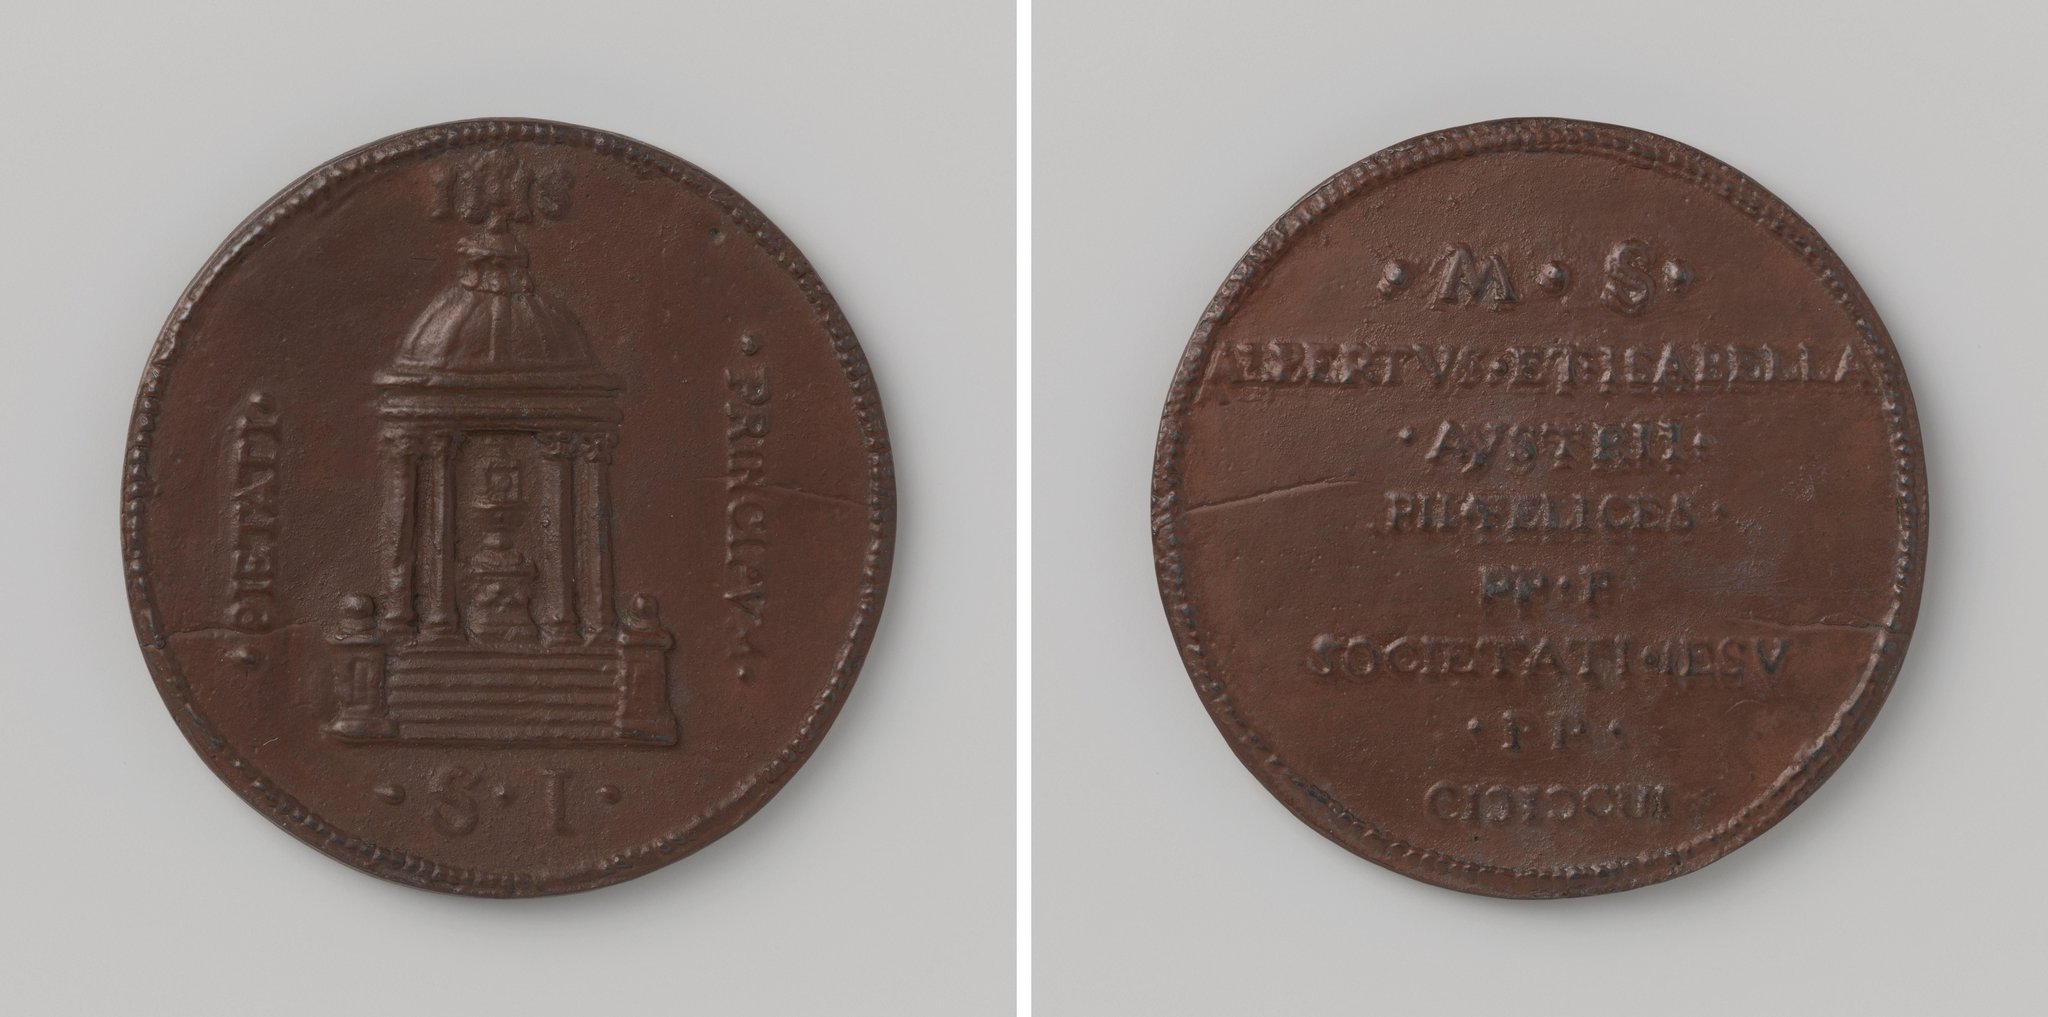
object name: copy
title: Legging van de eerste steen van de Jezuietenkerk te Brussel door Albrecht en Isabella van Oostenrijk, penning gelegd onder fundamenten van nieuwbouw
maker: Anonymous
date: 1600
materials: bronze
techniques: casting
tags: infante van spanje isabella clara eugenia, brussels, albrecht aartshertog van oostenrijk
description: Bronzen penning. Voorzijde: kapel tussen opschriften. Keerzijde: opschrift.